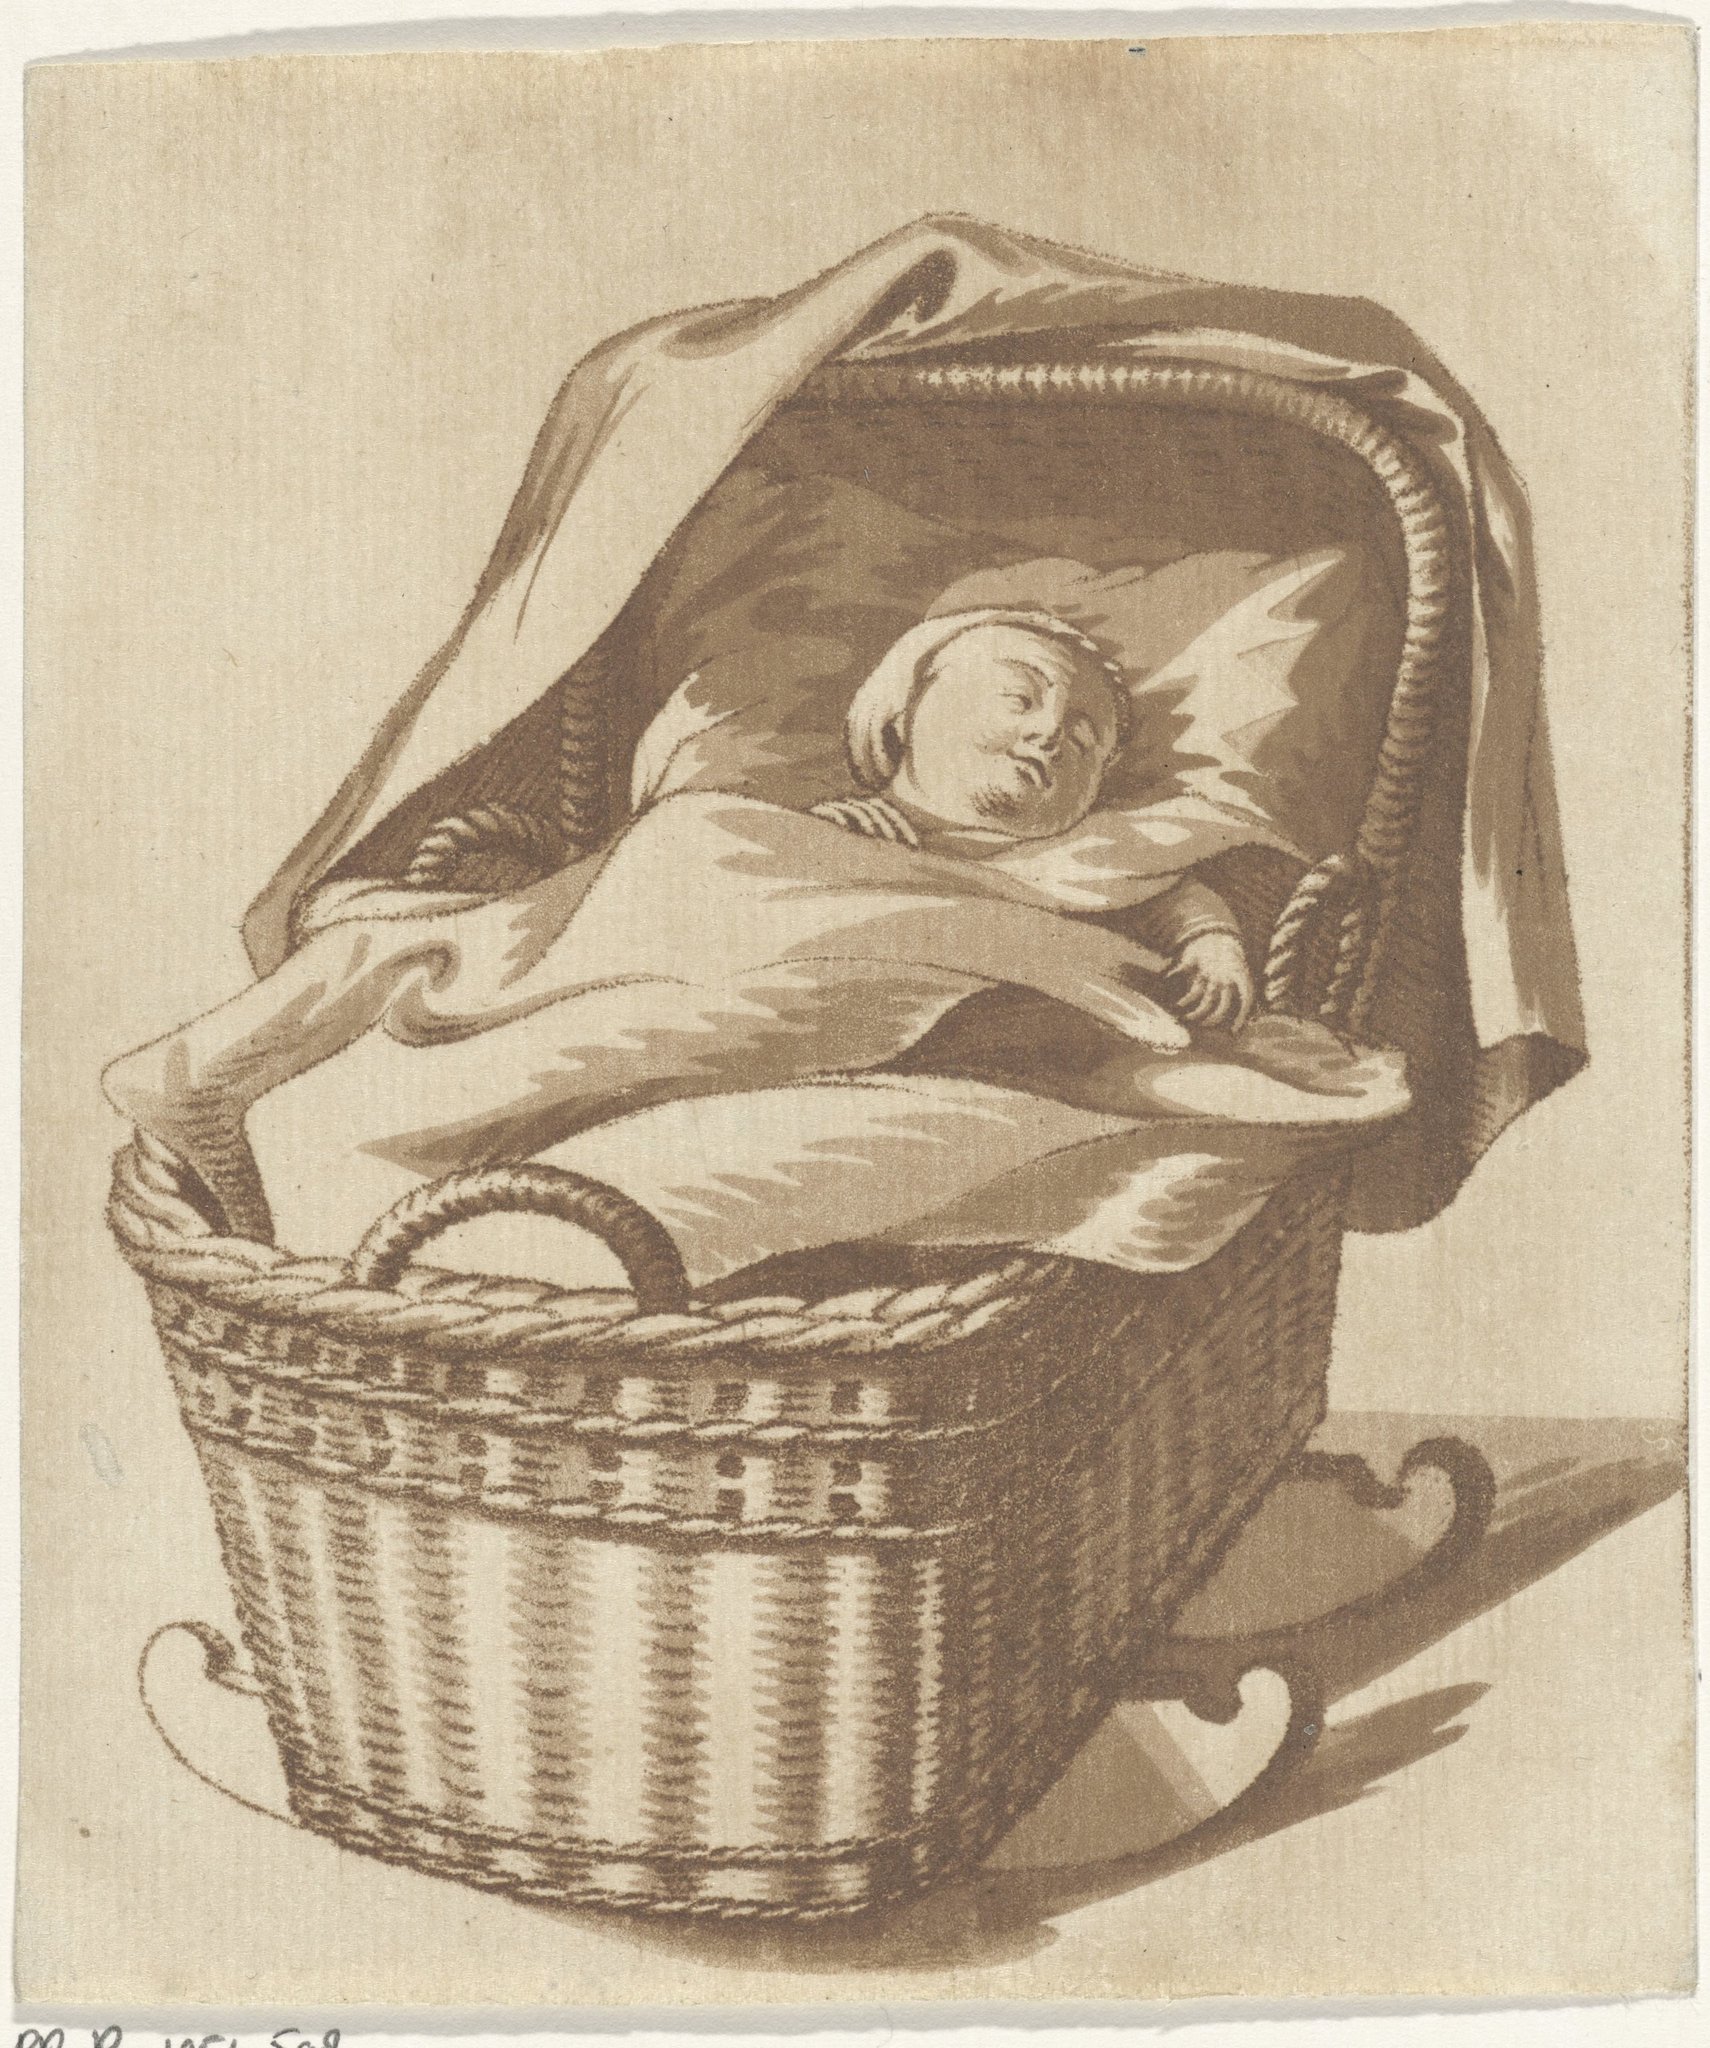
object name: print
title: Slapende baby in een wieg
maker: hermanus numan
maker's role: draughtsman, painter, print maker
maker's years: 1744-1820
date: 1754-1825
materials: paper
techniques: aquatint, etching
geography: netherlands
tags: sleeping in bed, cradle, crib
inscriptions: collector's mark: Lugt 2228